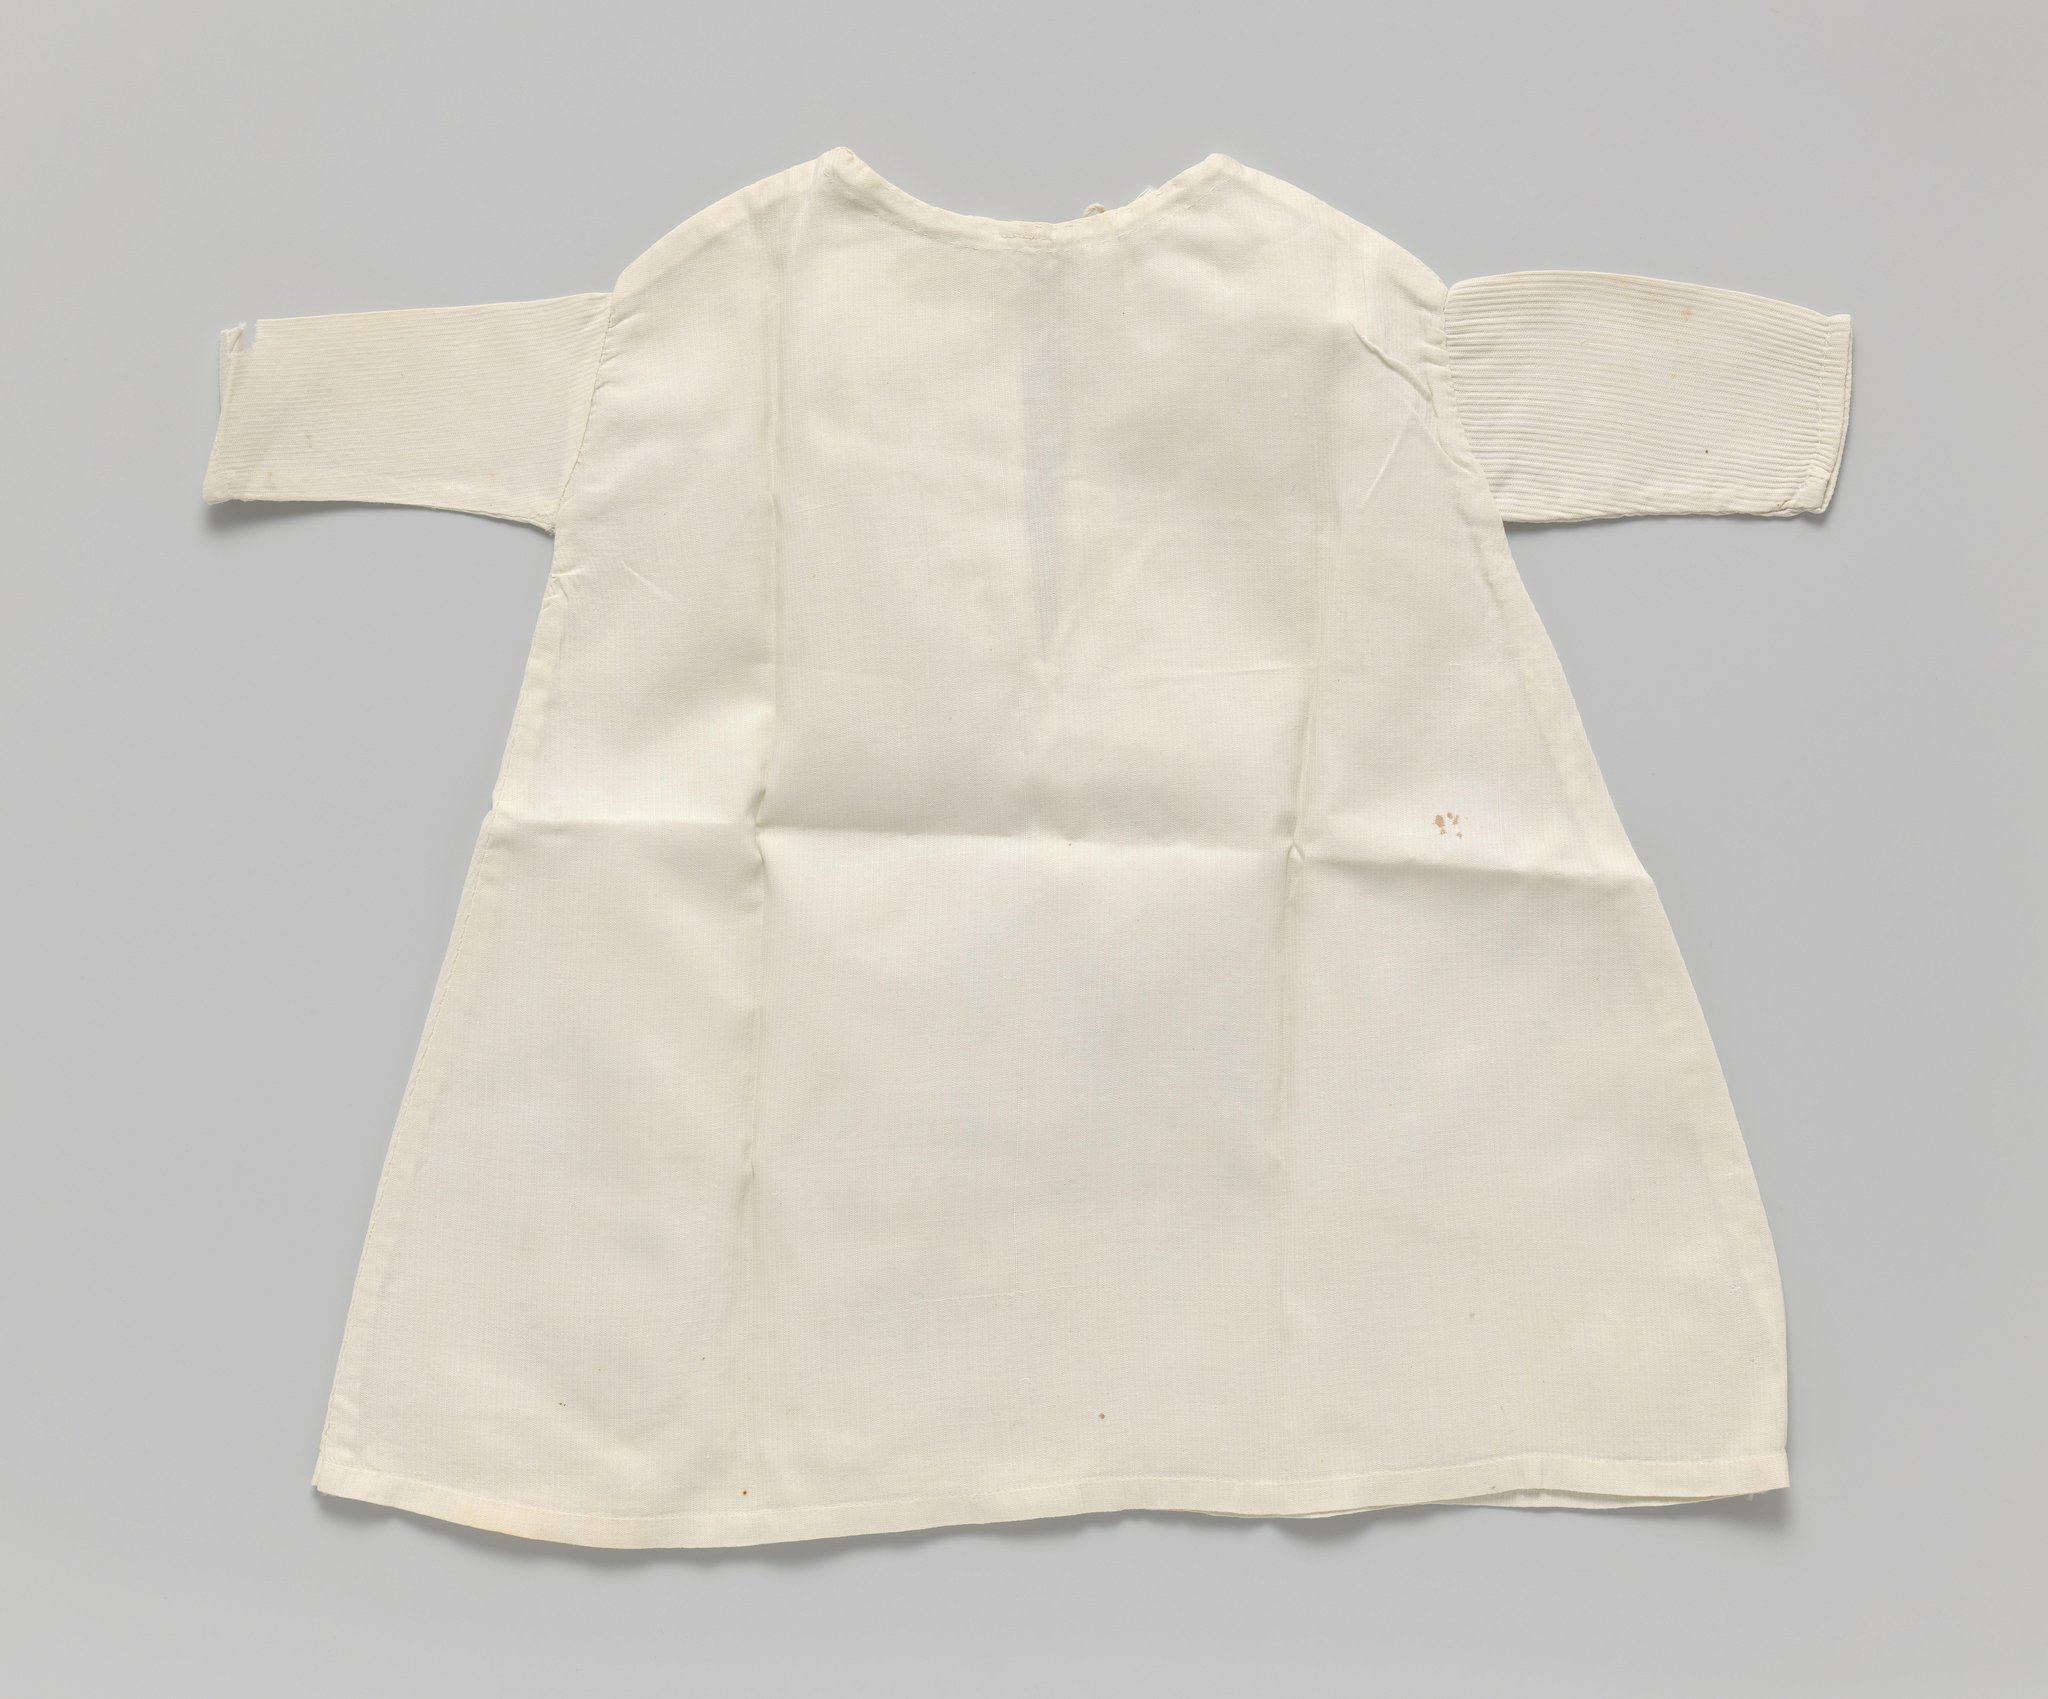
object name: doll's clothing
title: Hemd van wit katoen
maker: Anonymous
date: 1850-1920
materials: cotton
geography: europe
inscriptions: number: ‘RBK 15445’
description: Rond de hals een tunnel waardoor een koord; aan de achterzijde ter hoogte van de billen een strik van wit lint.